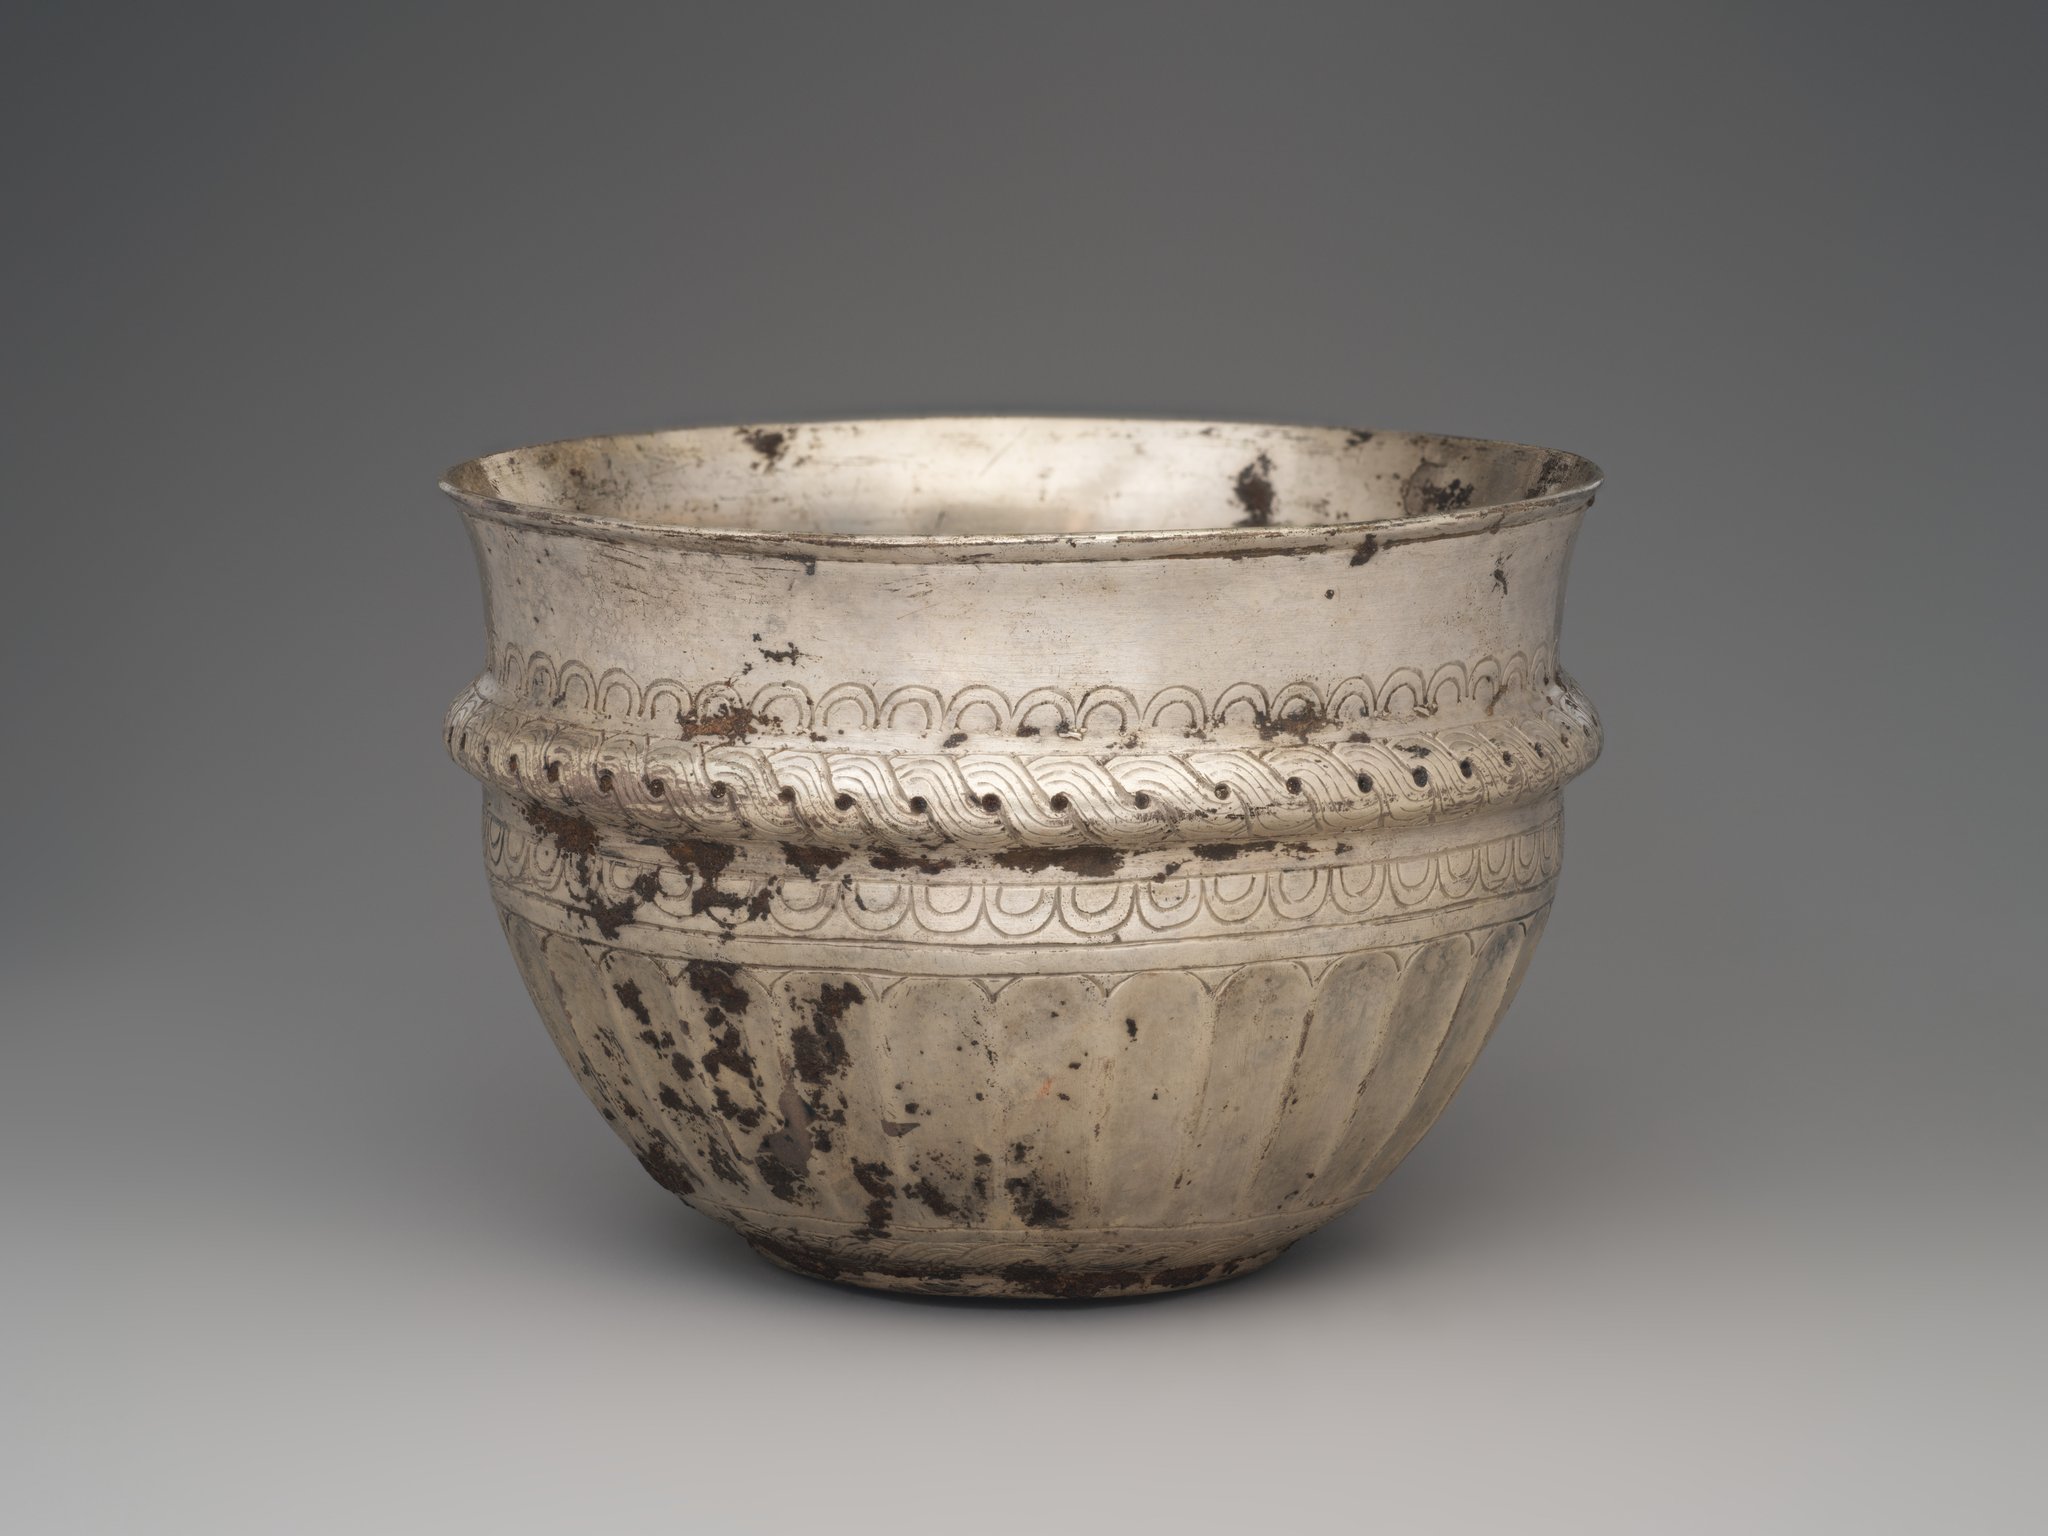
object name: cup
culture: iranian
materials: copper, silver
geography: iran